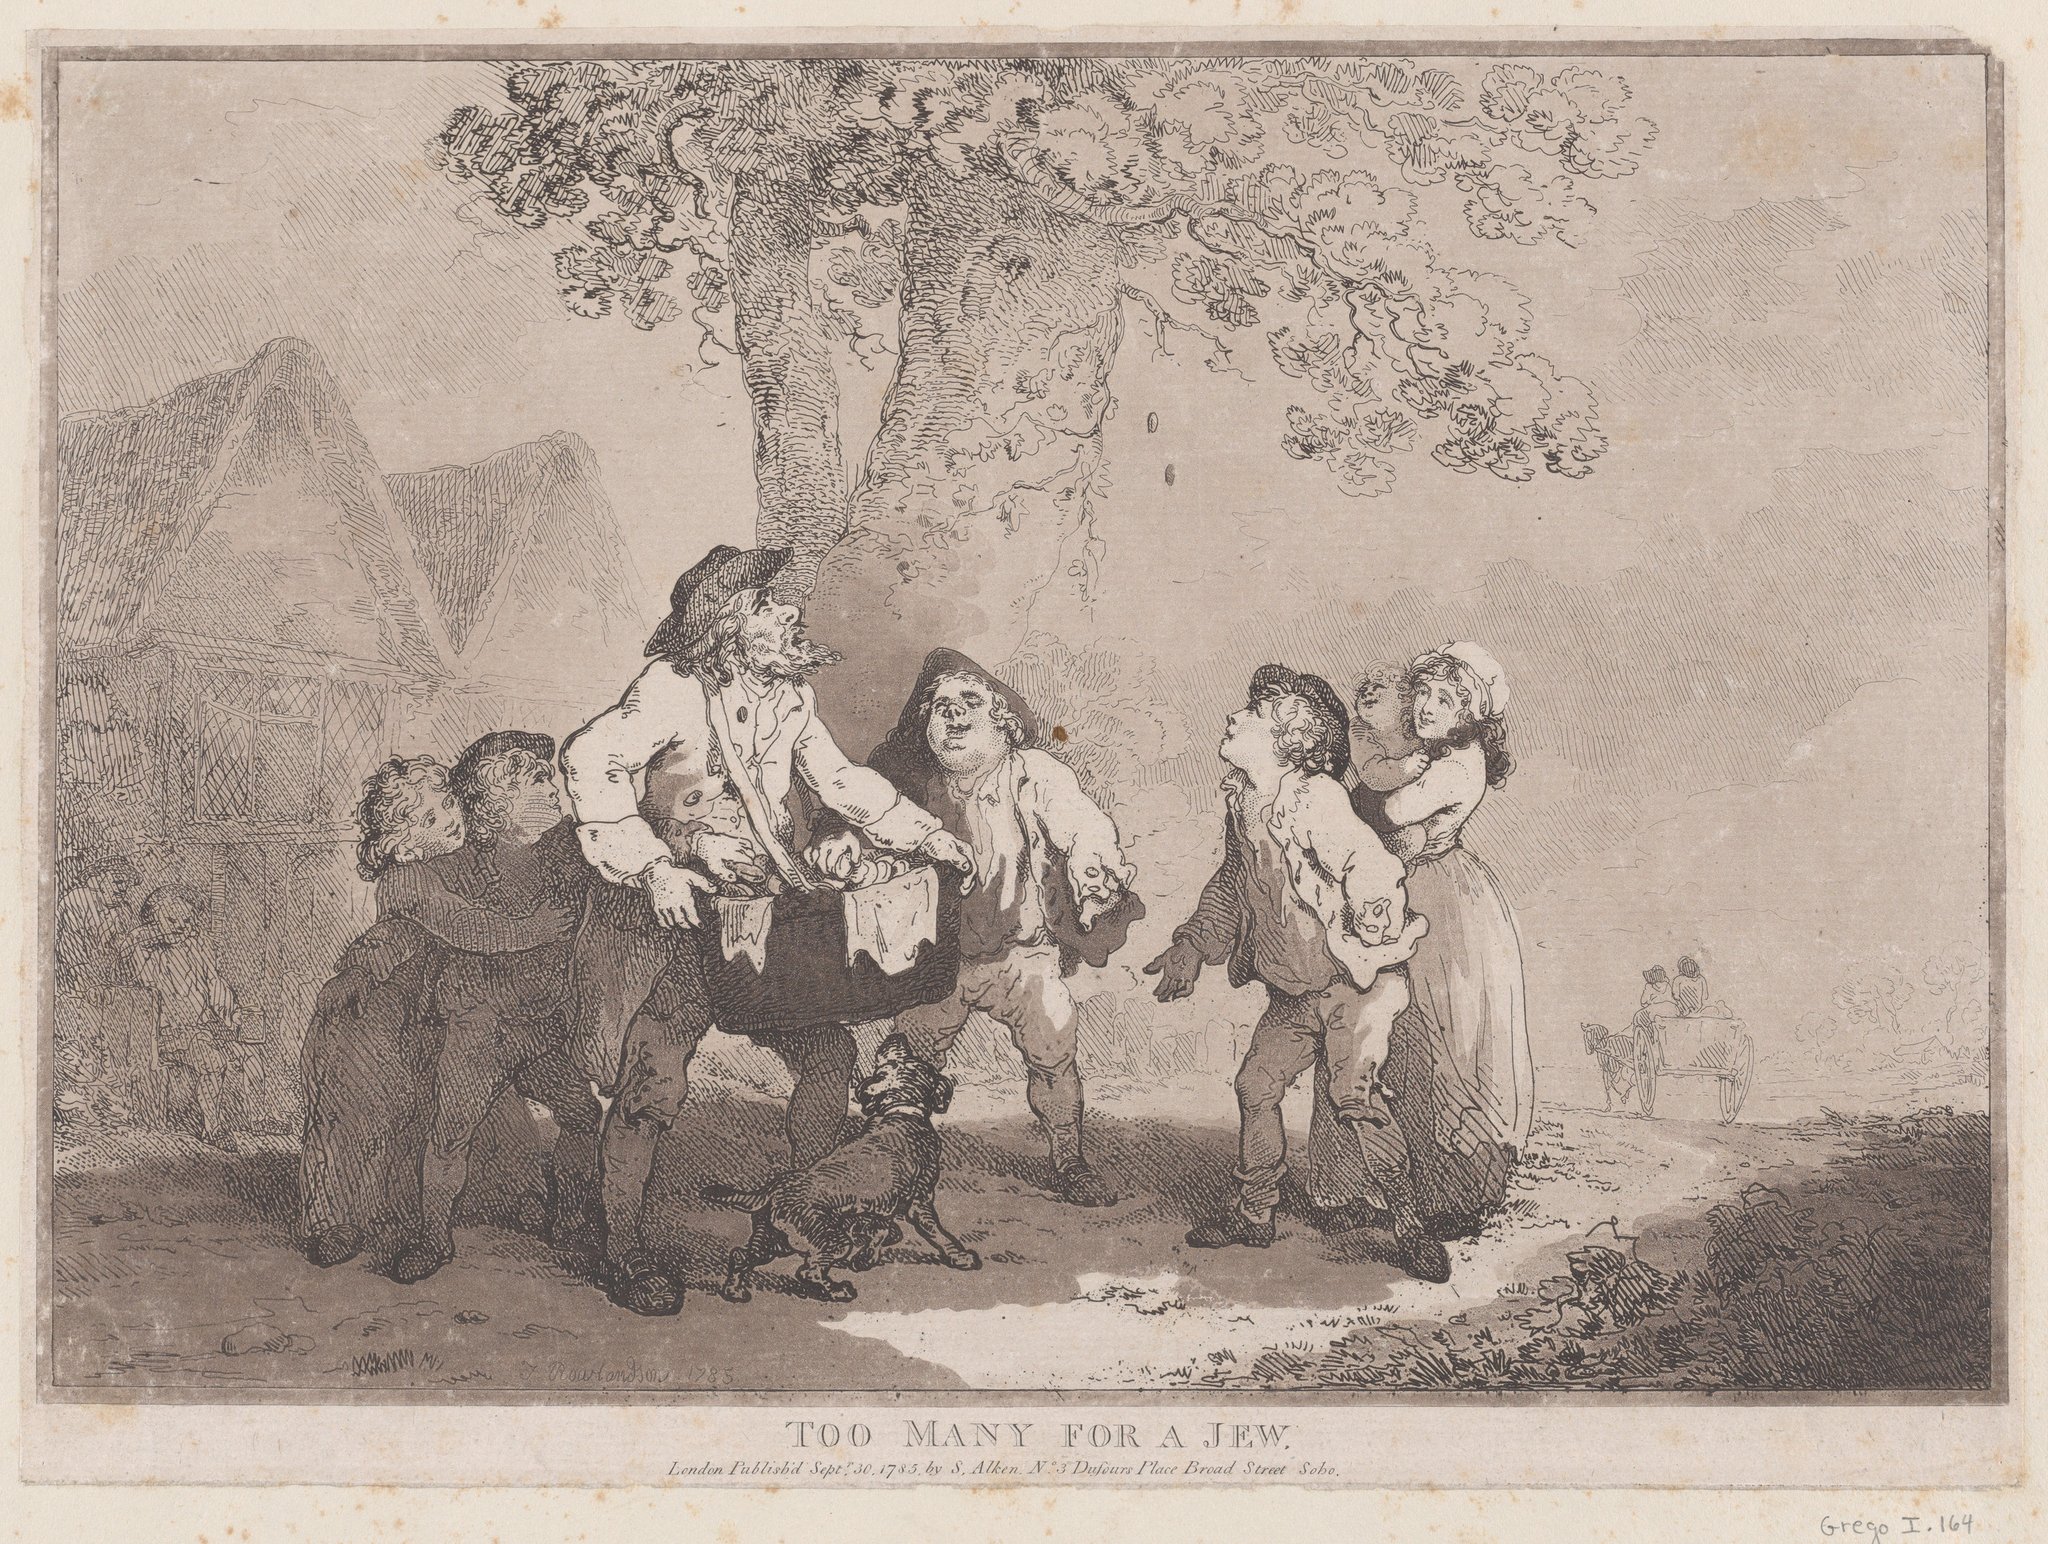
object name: print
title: Too Many for a Jew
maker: thomas rowlandson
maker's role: artist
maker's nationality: british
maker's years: 1757-1827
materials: ink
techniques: aquatint, etching, printing